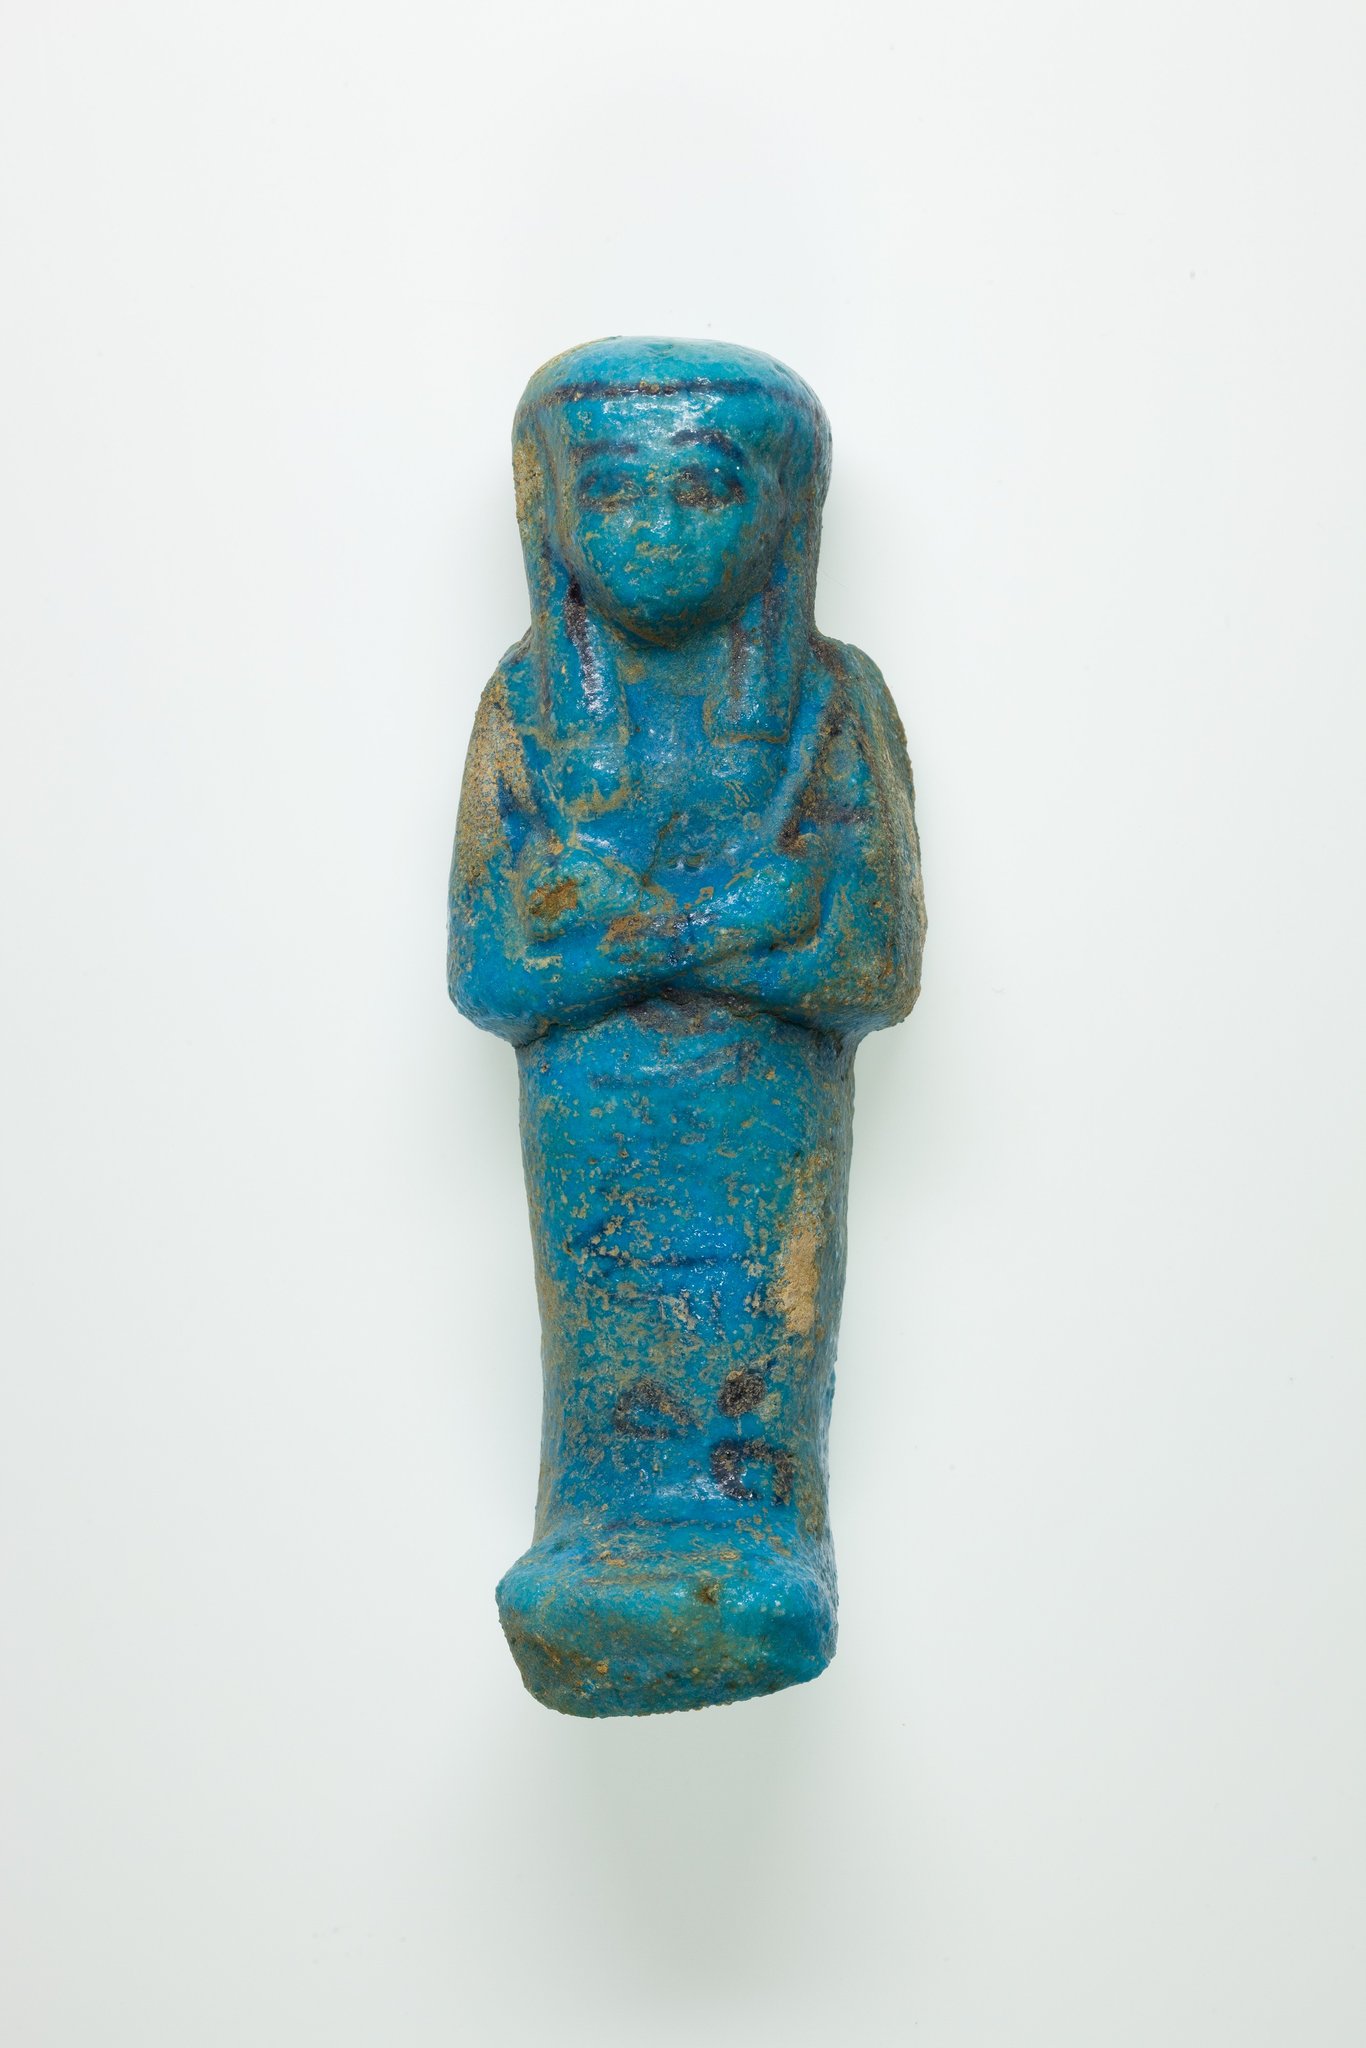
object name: worker shabti, henettawy c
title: Worker Shabti of Henettawy (C), Daughter of Isetemkheb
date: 990-970 BCE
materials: faience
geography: egypt